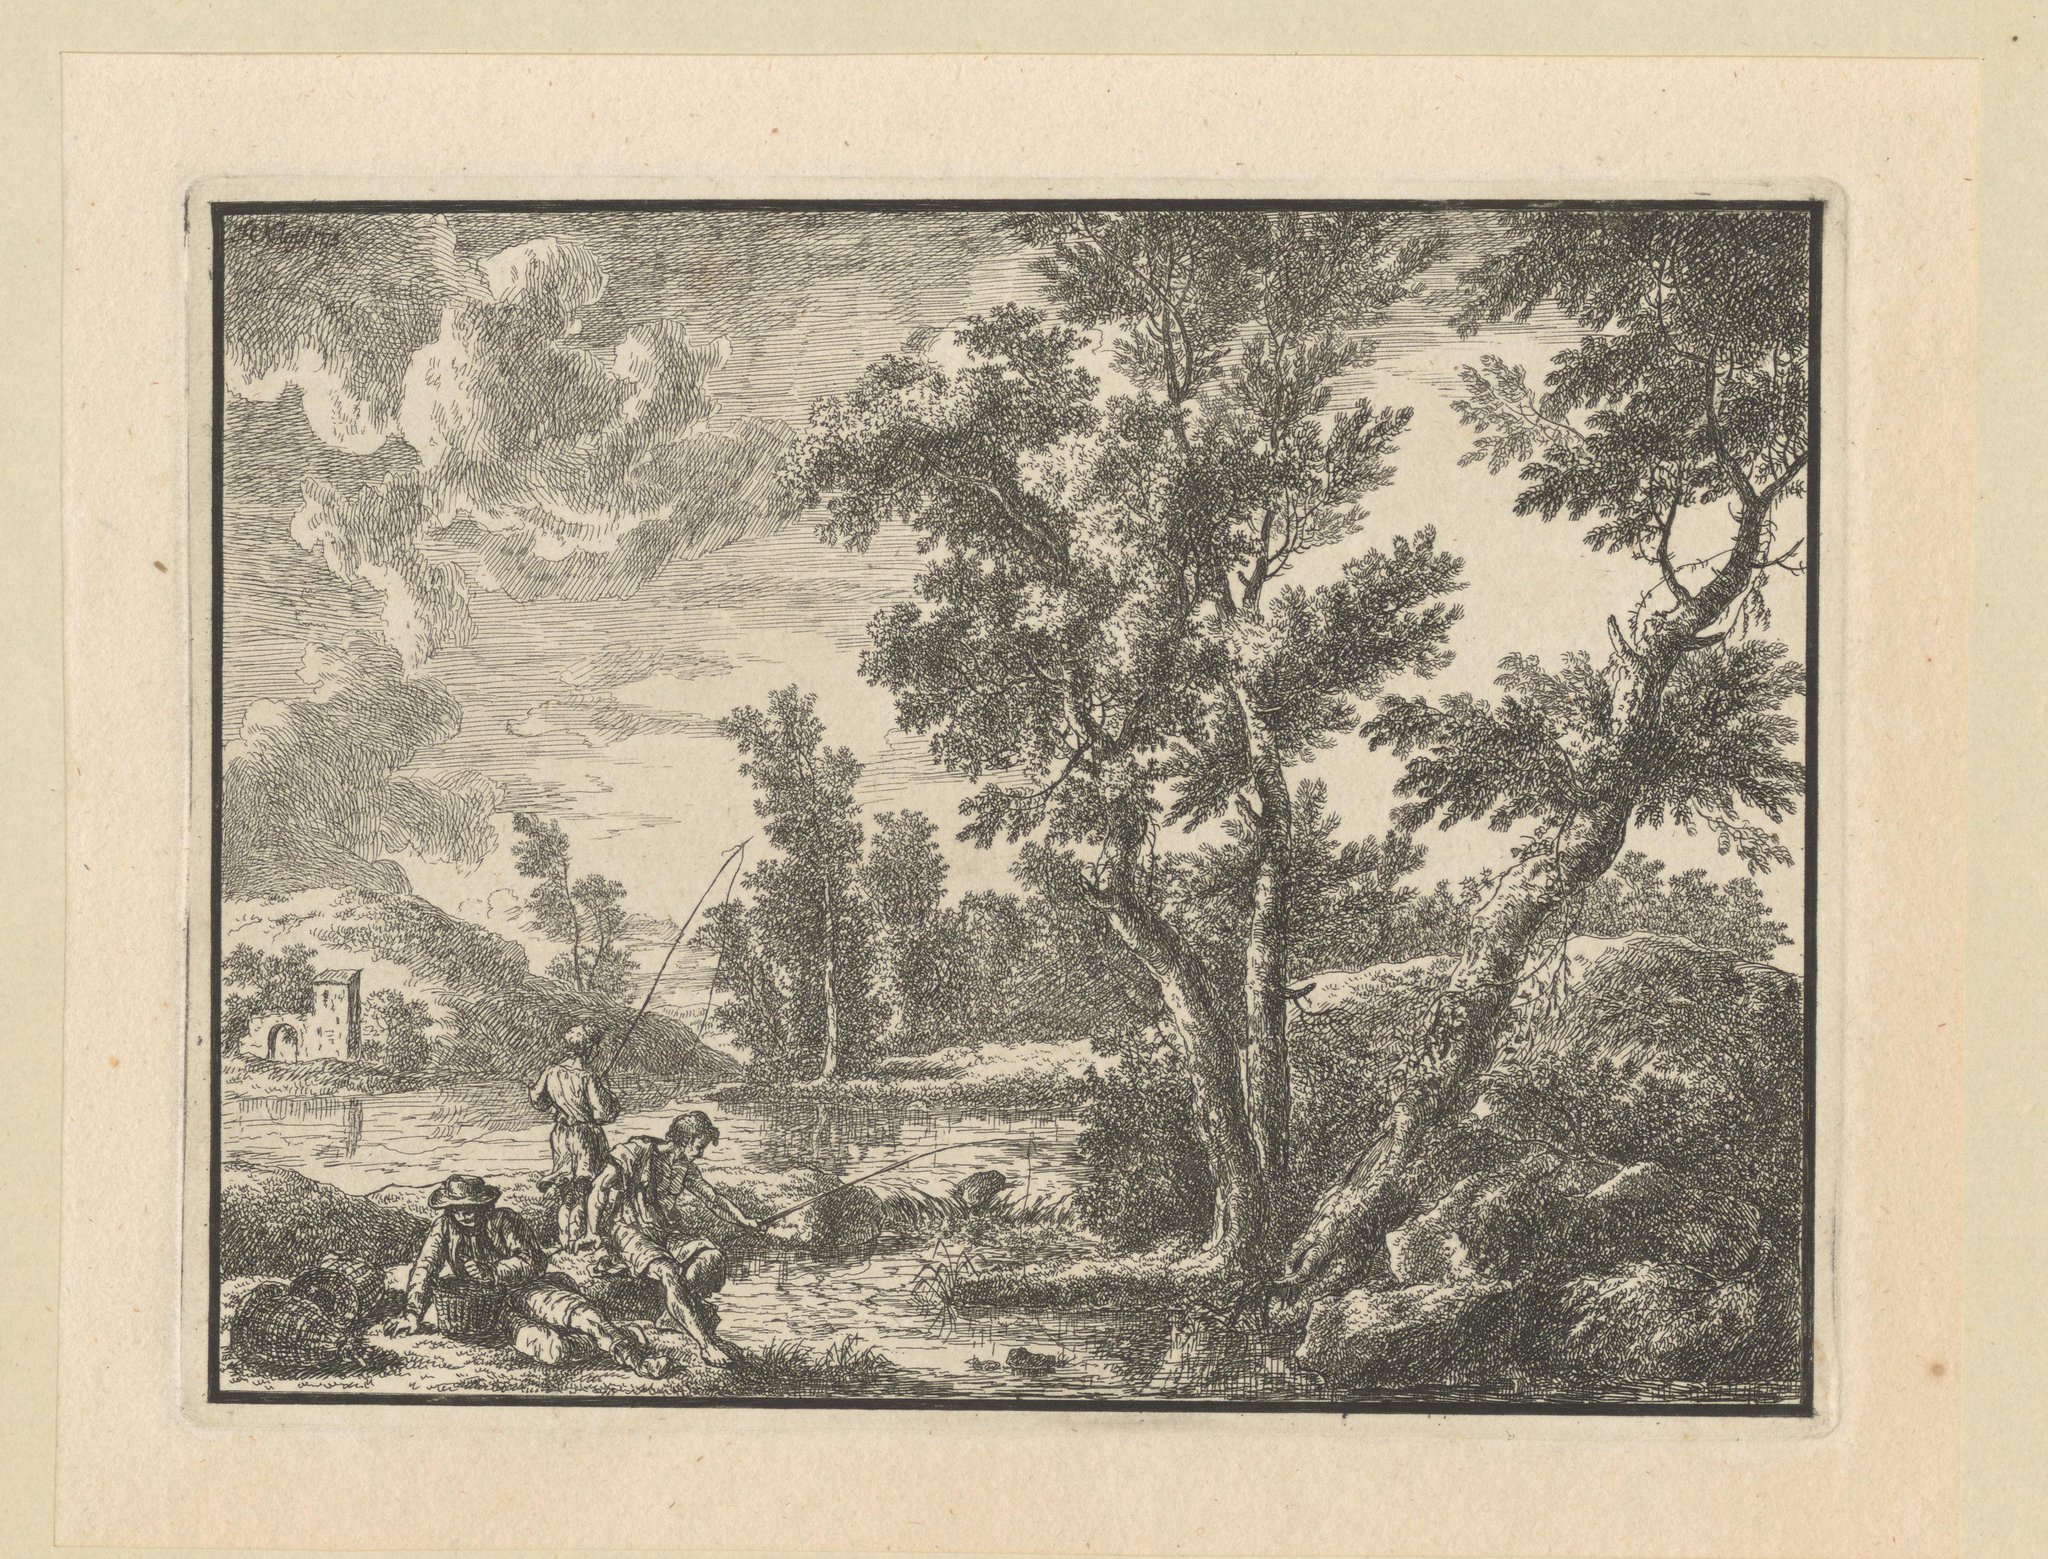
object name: print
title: Landschap met vissers aan de oever van een rivier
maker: friedrich christian klass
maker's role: painter, print maker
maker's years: 1752-1827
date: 1775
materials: paper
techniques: etching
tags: low hill country, (traveller) resting in the open air, cattle driving, cattle driver, angling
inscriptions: collector's mark: Lugt 240